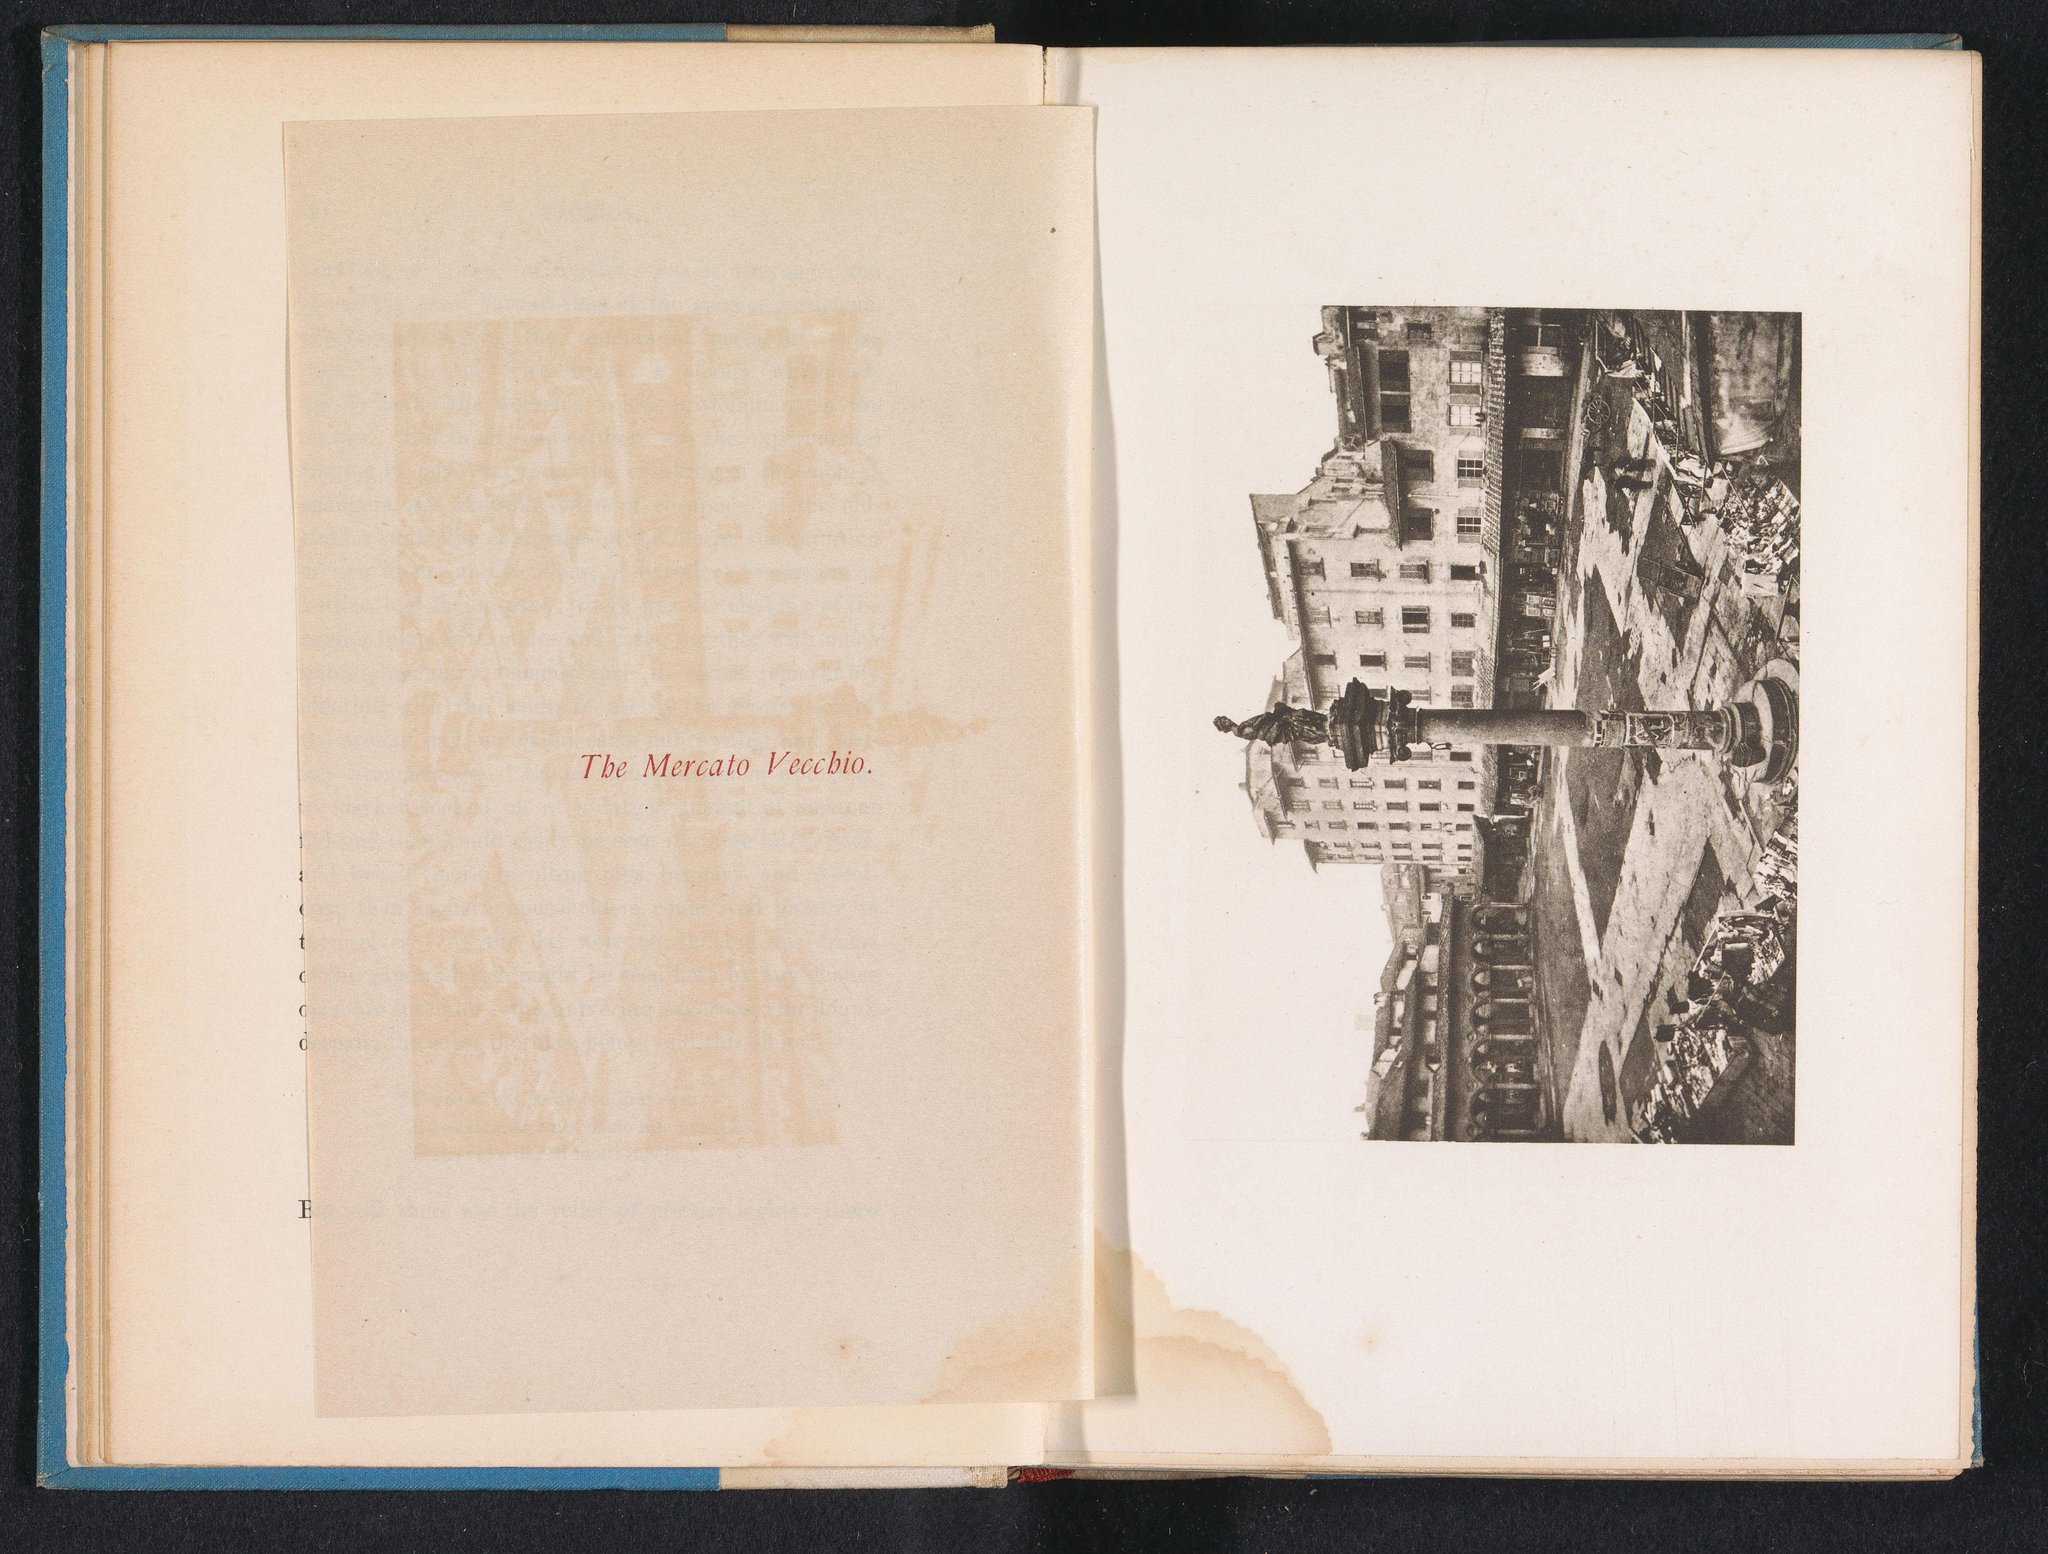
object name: photomechanical print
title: Gezicht op de Mercato Vecchio en de Colonna dell'Abbondanza te Florence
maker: Anonymous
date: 1880-1890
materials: paper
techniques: photoaquatint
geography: florence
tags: column, pillar ~ architecture, market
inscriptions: title: ‘The Mercato Vecchio.’